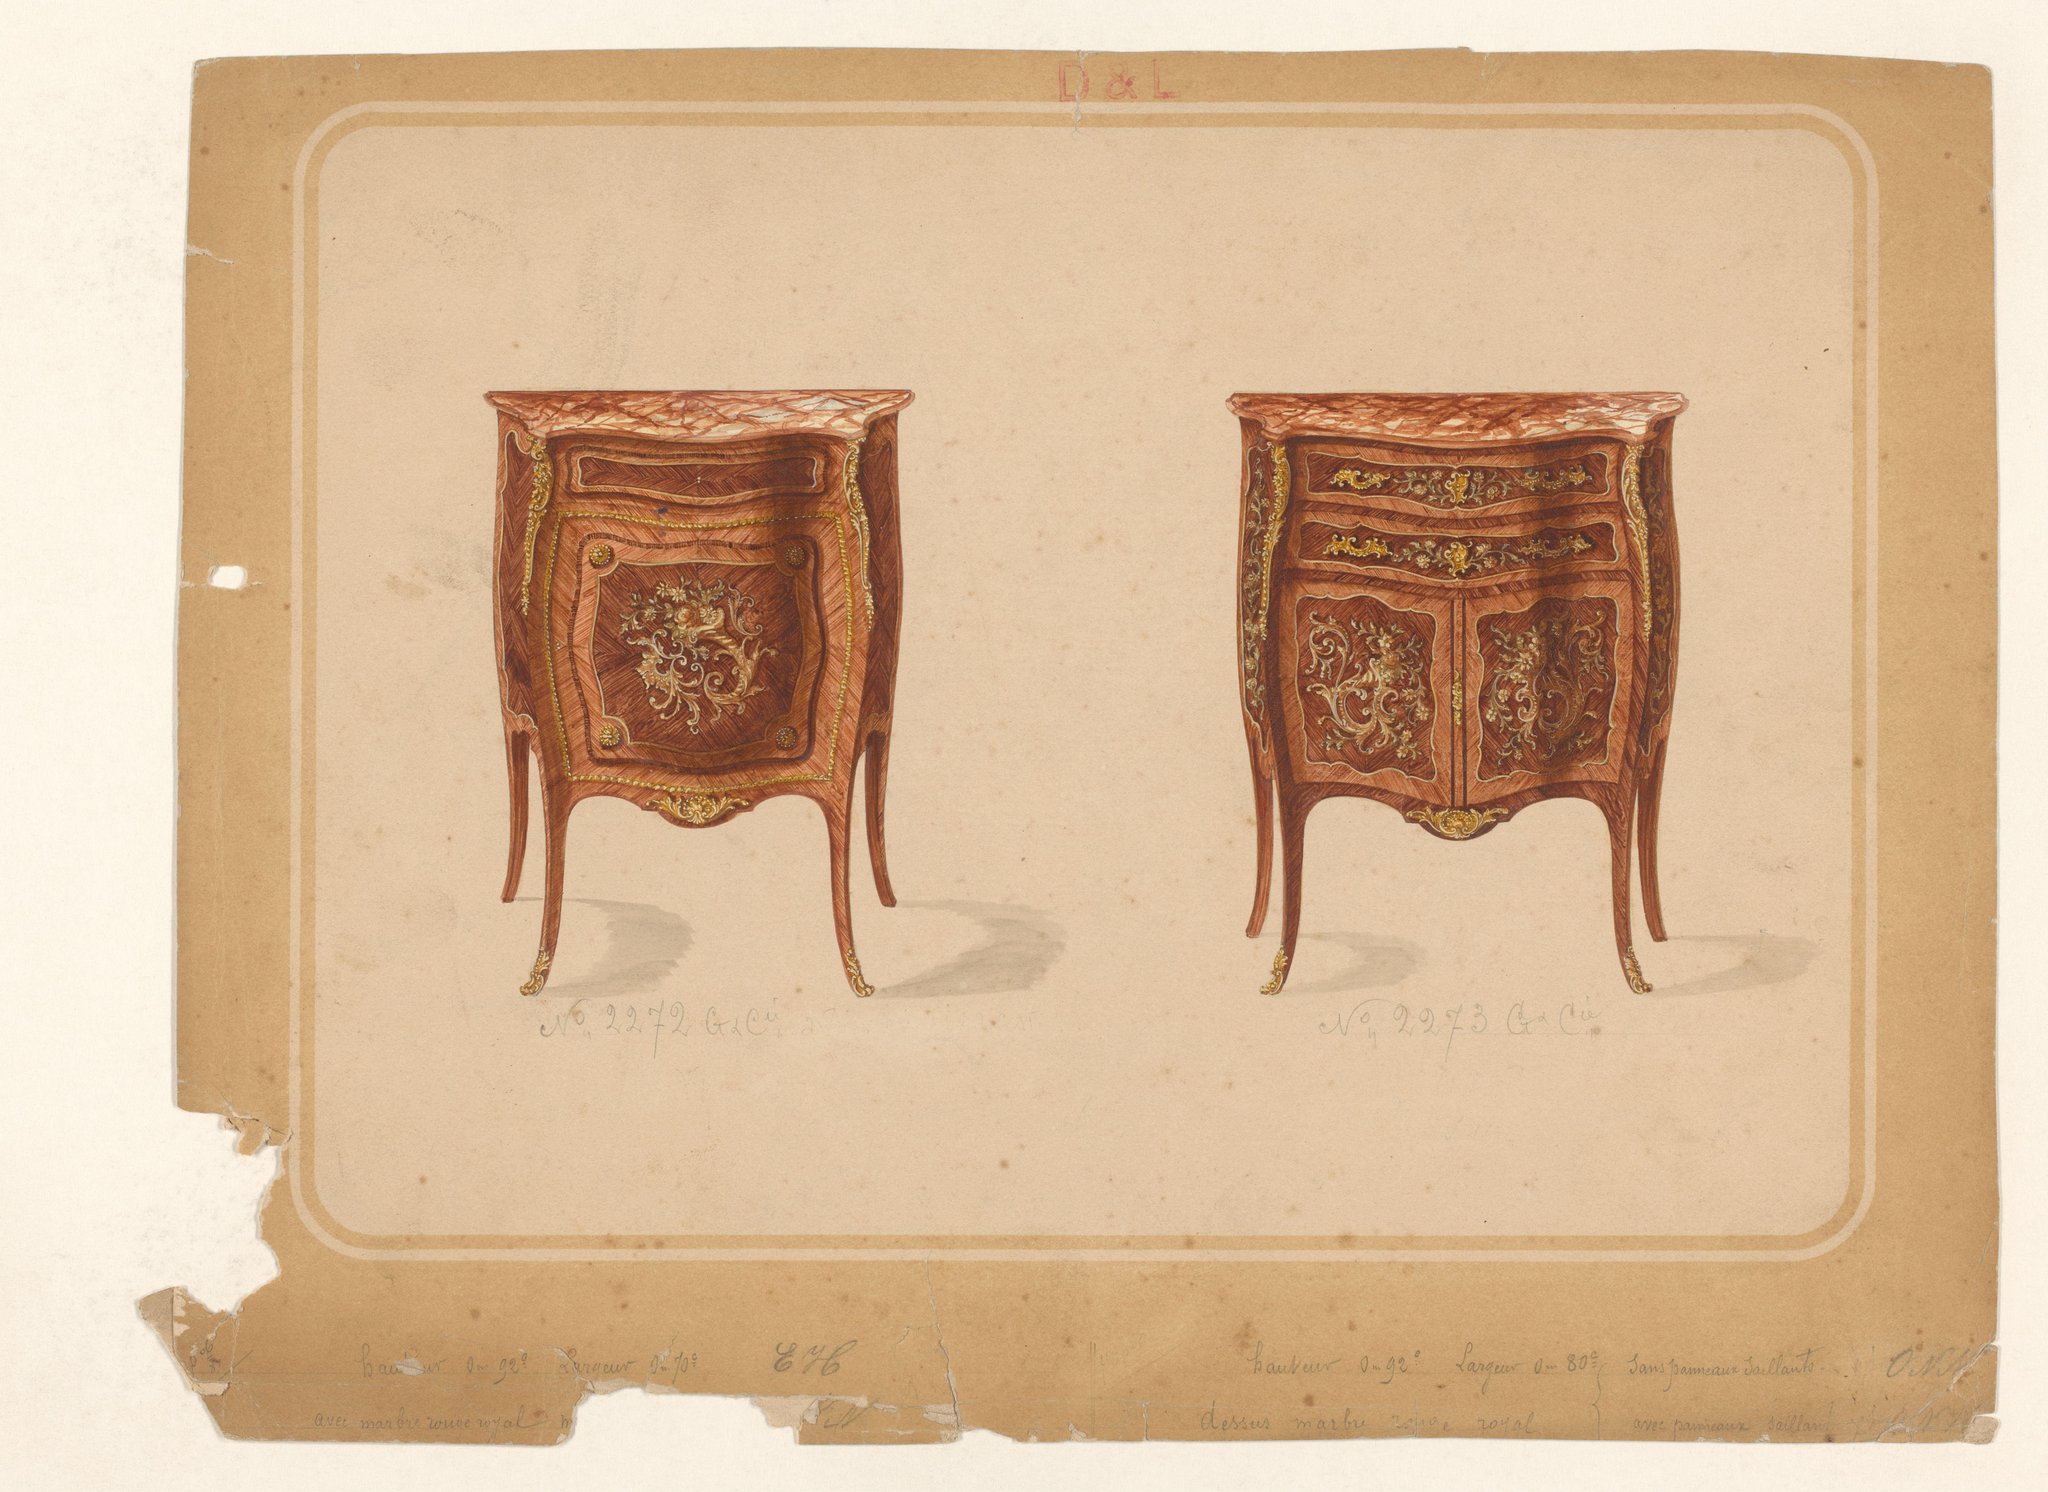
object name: print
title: Twee kasten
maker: Anonymous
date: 1800-1900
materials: paper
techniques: hand coloring, lithograph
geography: france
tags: furniture for storage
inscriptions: stamp: ‘D & L’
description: Twee lage geornamenteerde kasten. In potlood genummerd 2272 en 2273.